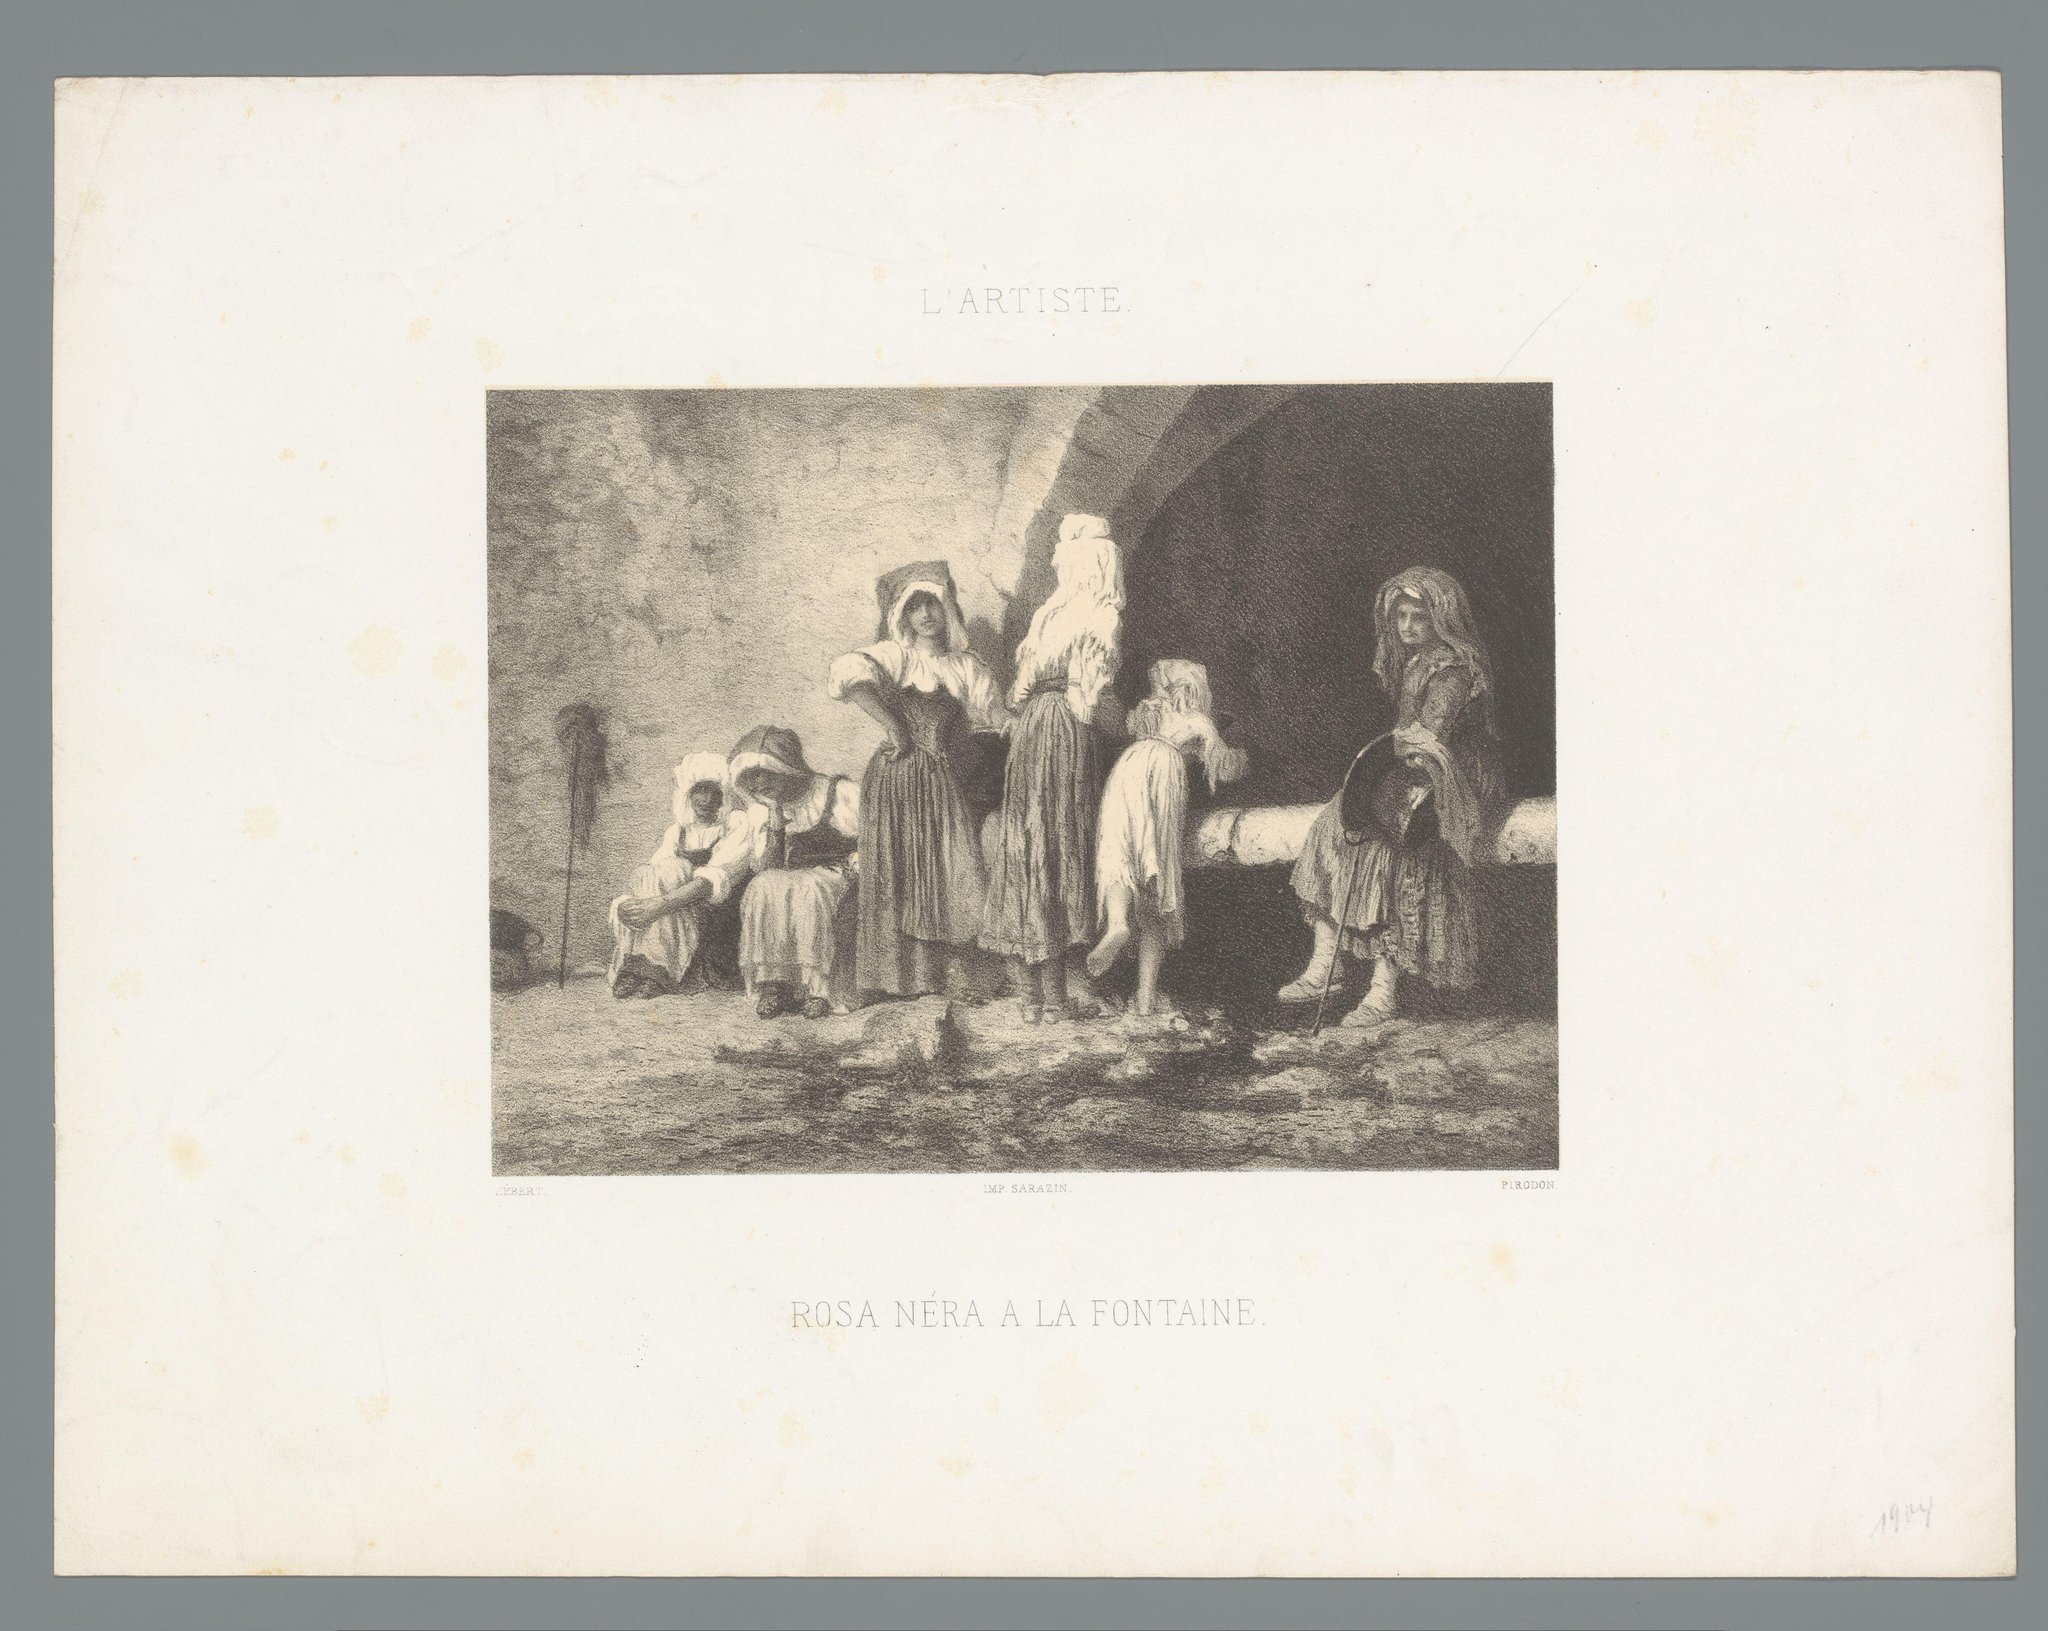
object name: print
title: Vrouwen bij een waterbassin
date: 1863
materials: paper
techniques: lithograph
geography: paris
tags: well, adult woman (+ five persons)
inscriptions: collector's mark: Lugt 2228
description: Prent gebruikt in: L'Artiste, 1863, dl. 1.